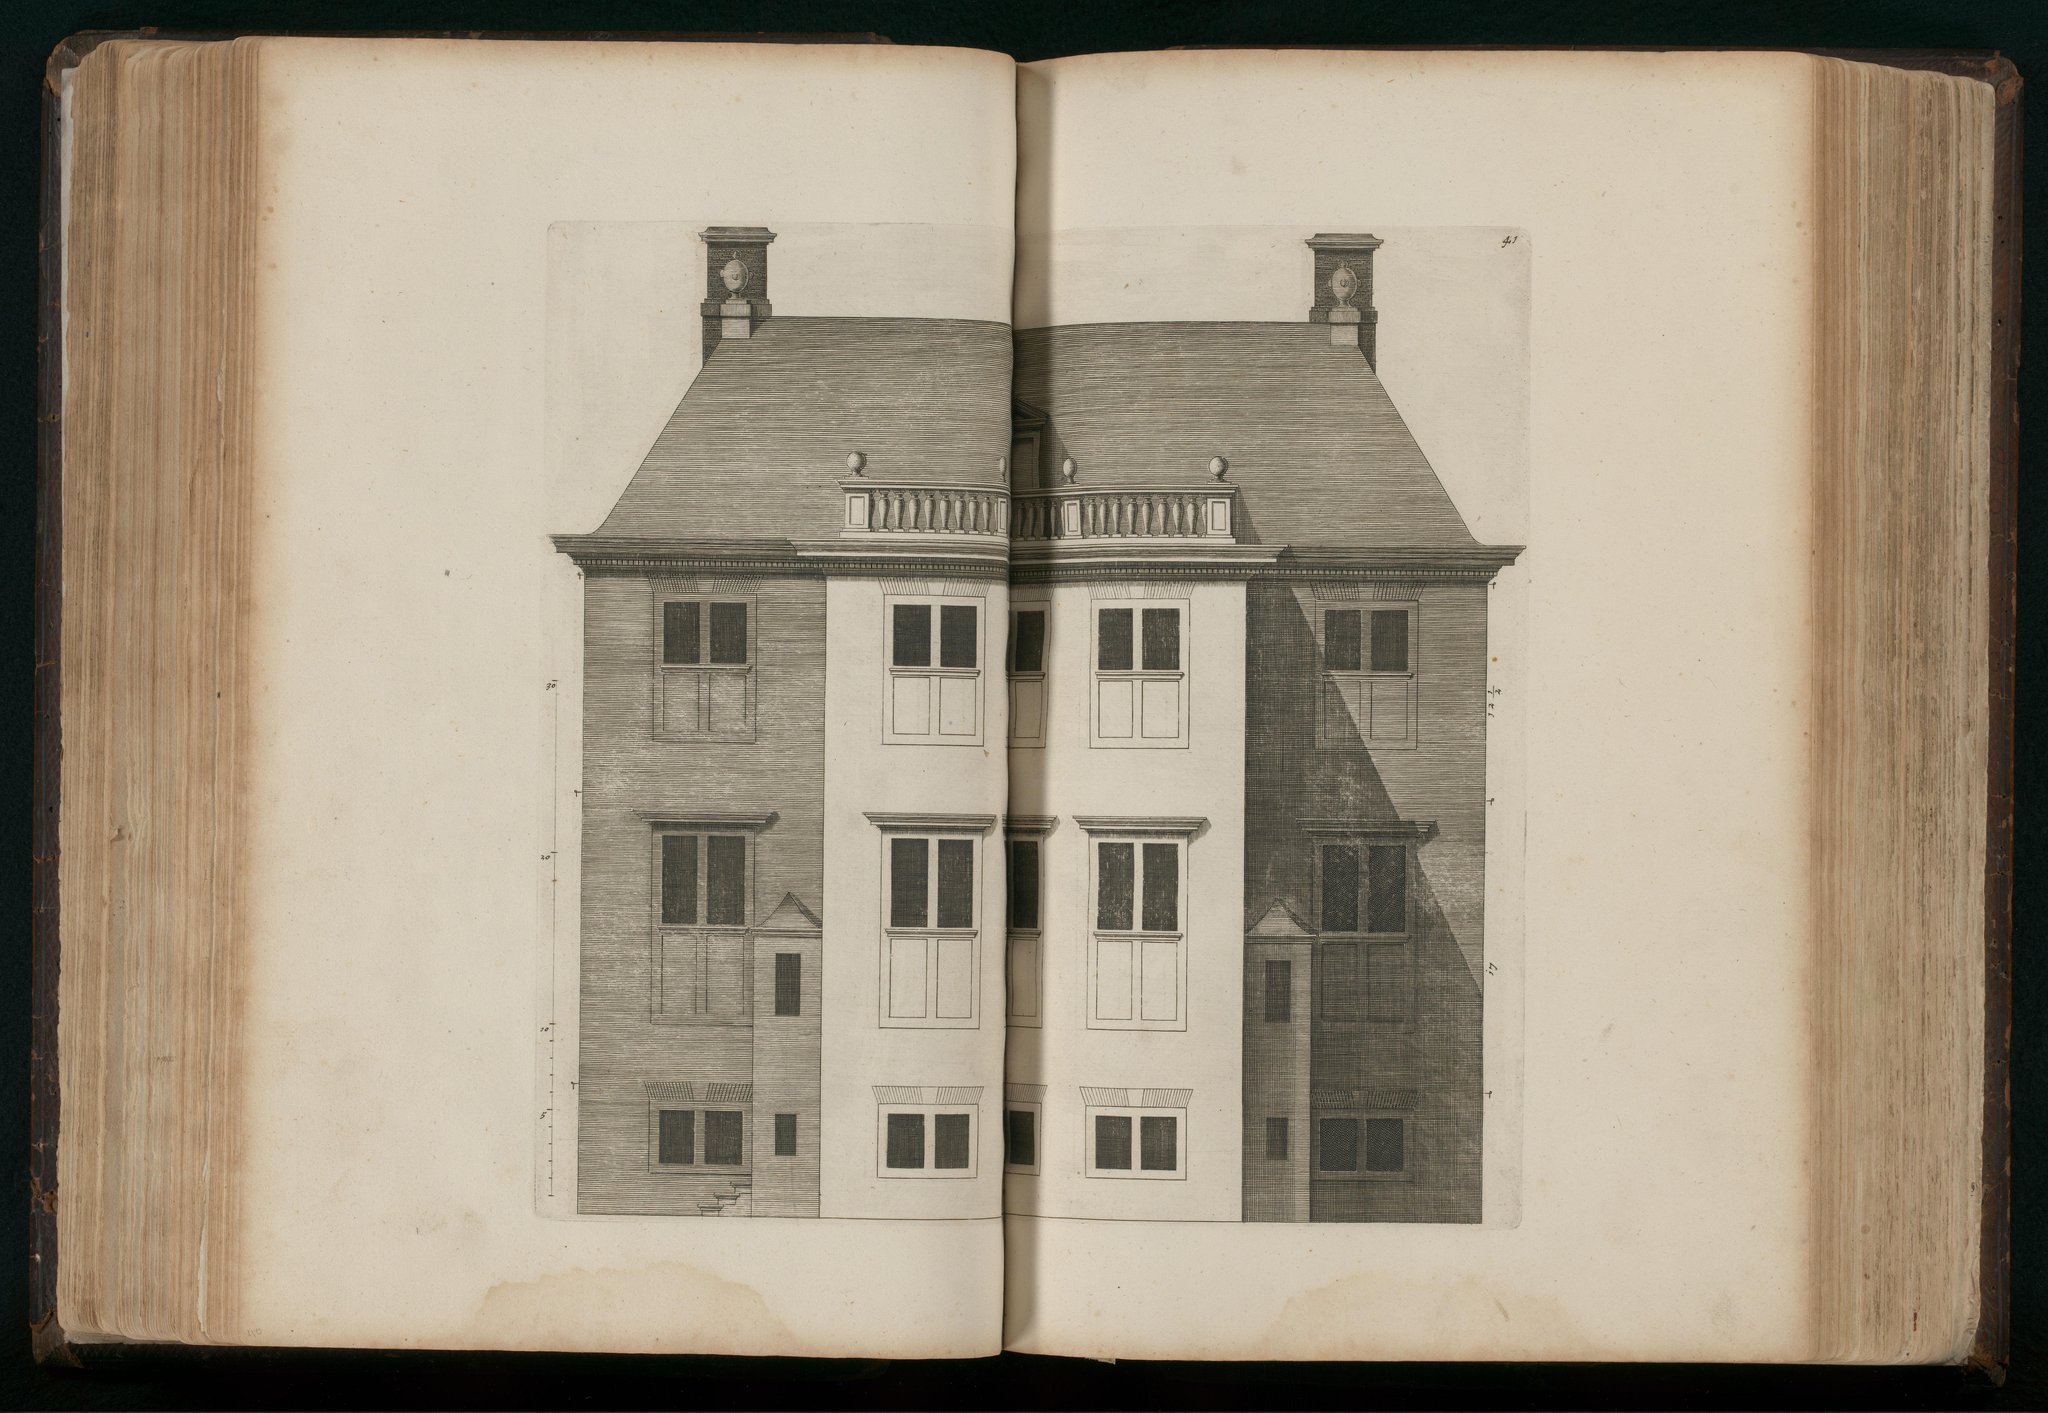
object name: print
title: Achtergevel van het landhuis Driemond te Weesp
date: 1648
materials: paper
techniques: engraving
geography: amsterdam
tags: urban housing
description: Prent uit: Afbeelsels der voornaemste gebouwen uyt alle die Philips Vingboons geordineert heeft. Amsterdam: Philips en Johannes Vinckboons en Johannes Willemszoon Blaeu, 1648.